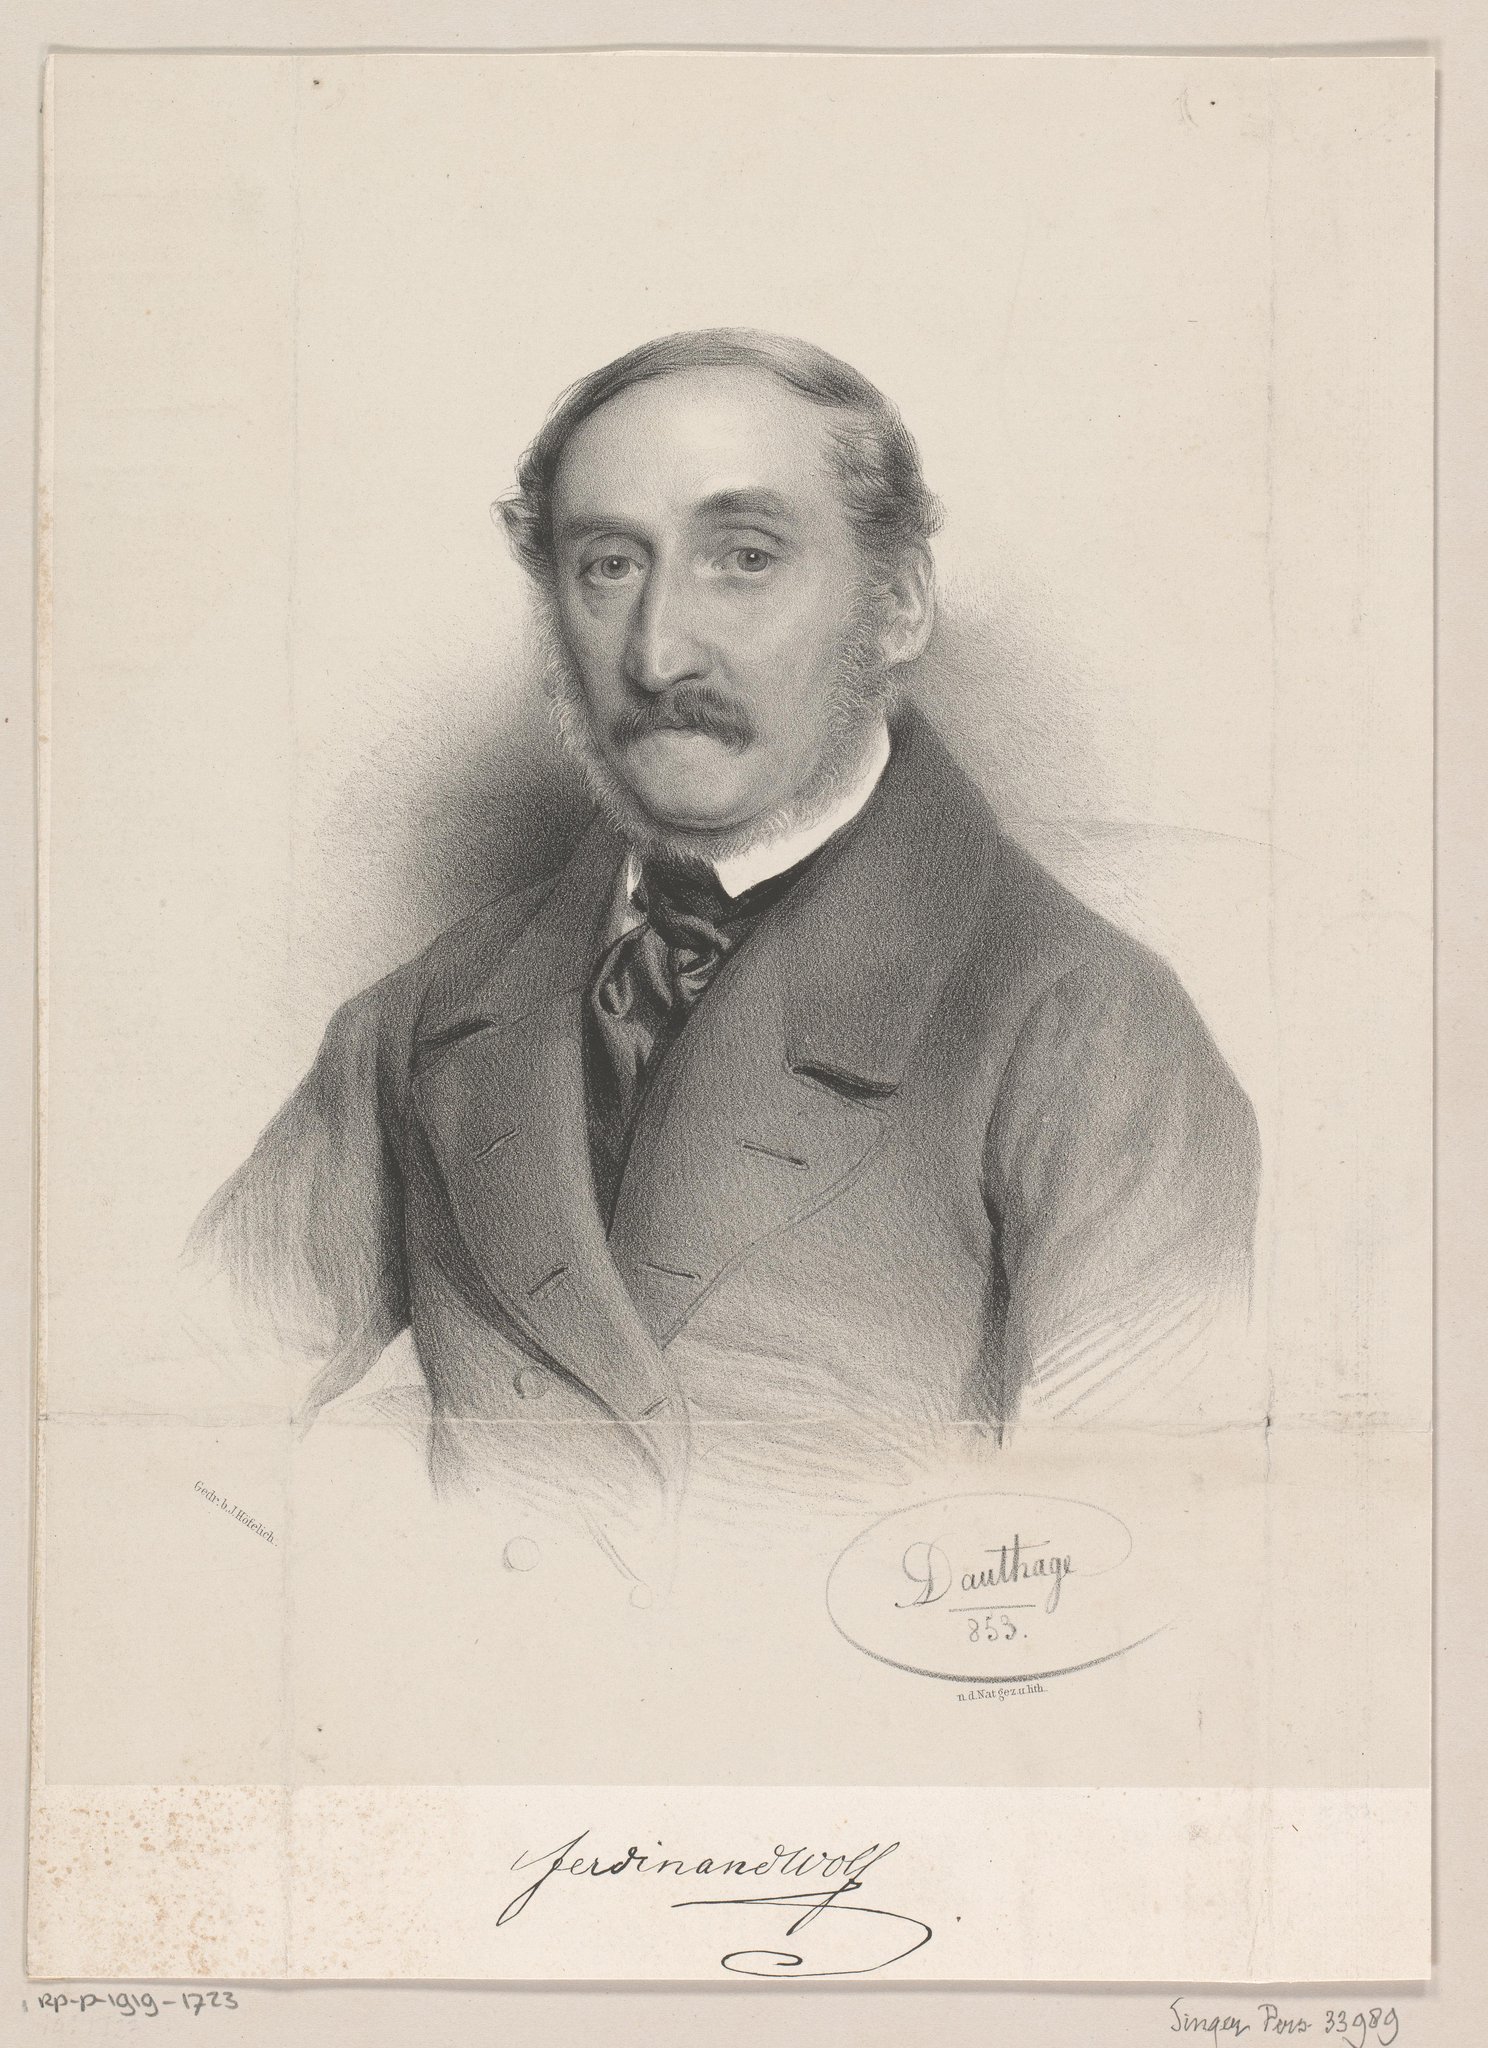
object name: print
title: Portret van Ferdinand Wolf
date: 1853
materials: paper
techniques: lithograph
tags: historical persons, portrait of a writer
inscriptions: collector's mark: Lugt 2228